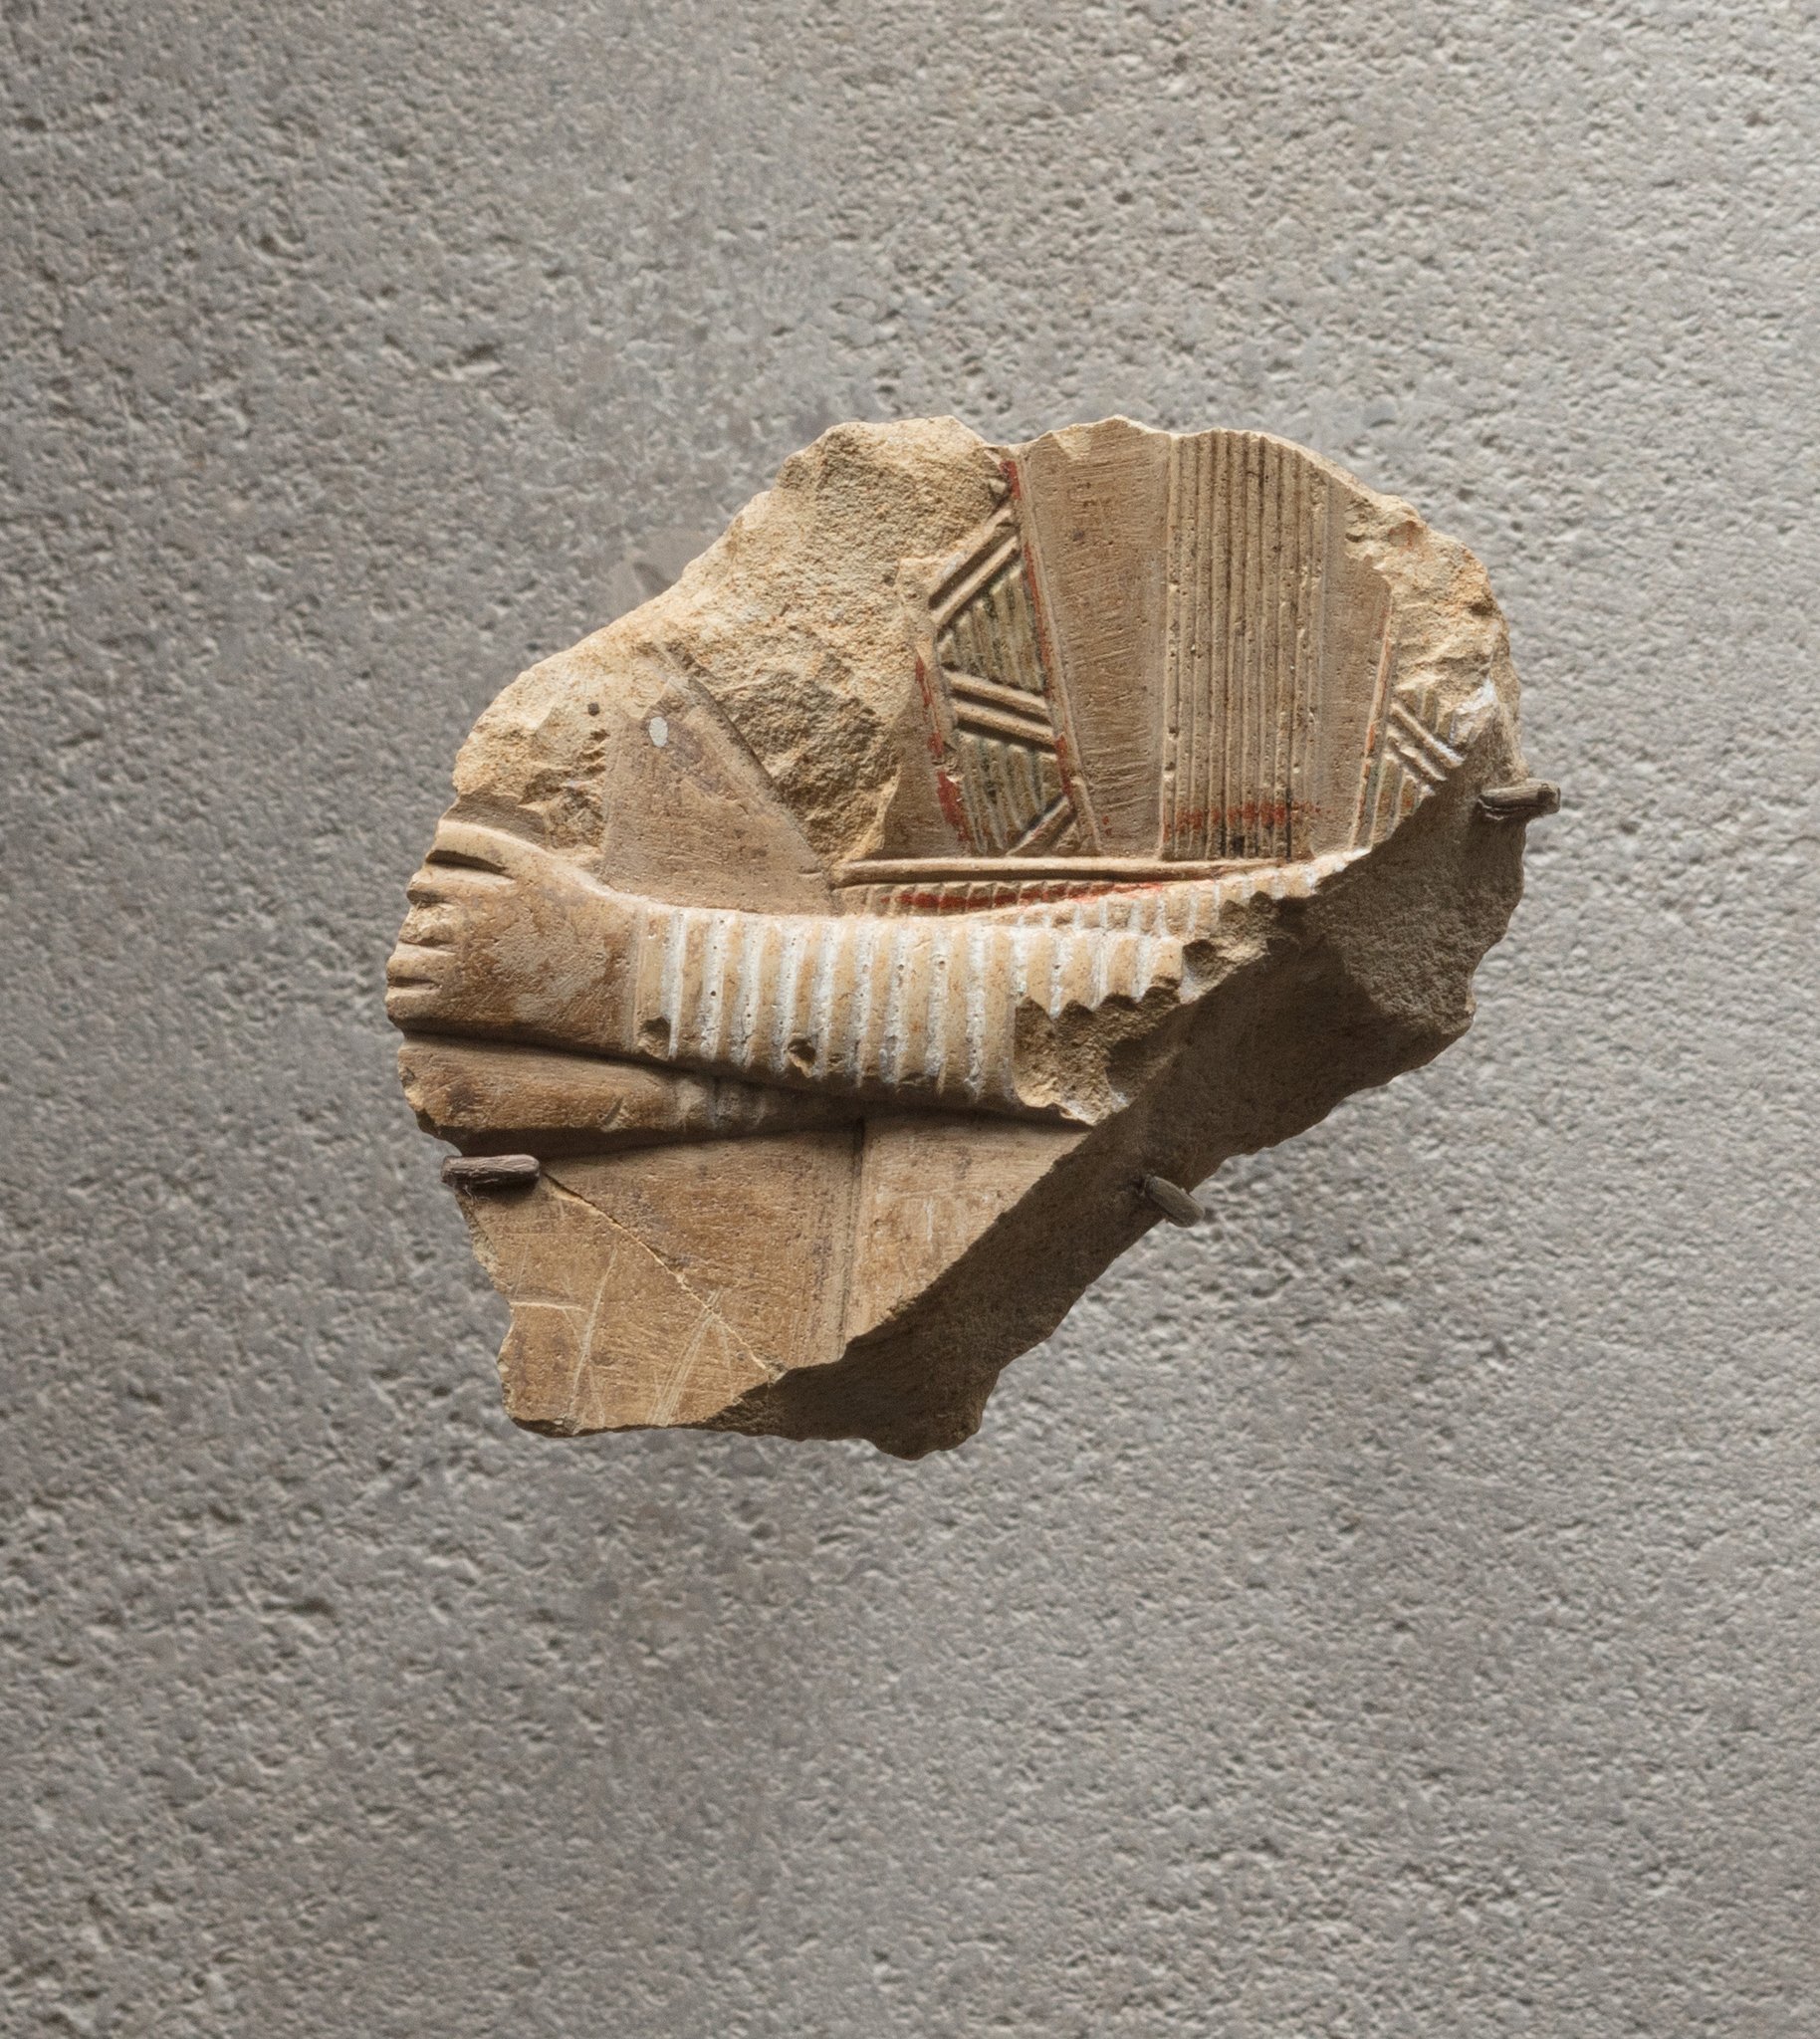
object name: relief, part of richly adorned female figure, tomb of neferu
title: Relief of part of a richly adorned female figure - see 26.3.353-3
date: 2051-2030 BCE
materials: limestone, paint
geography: egypt